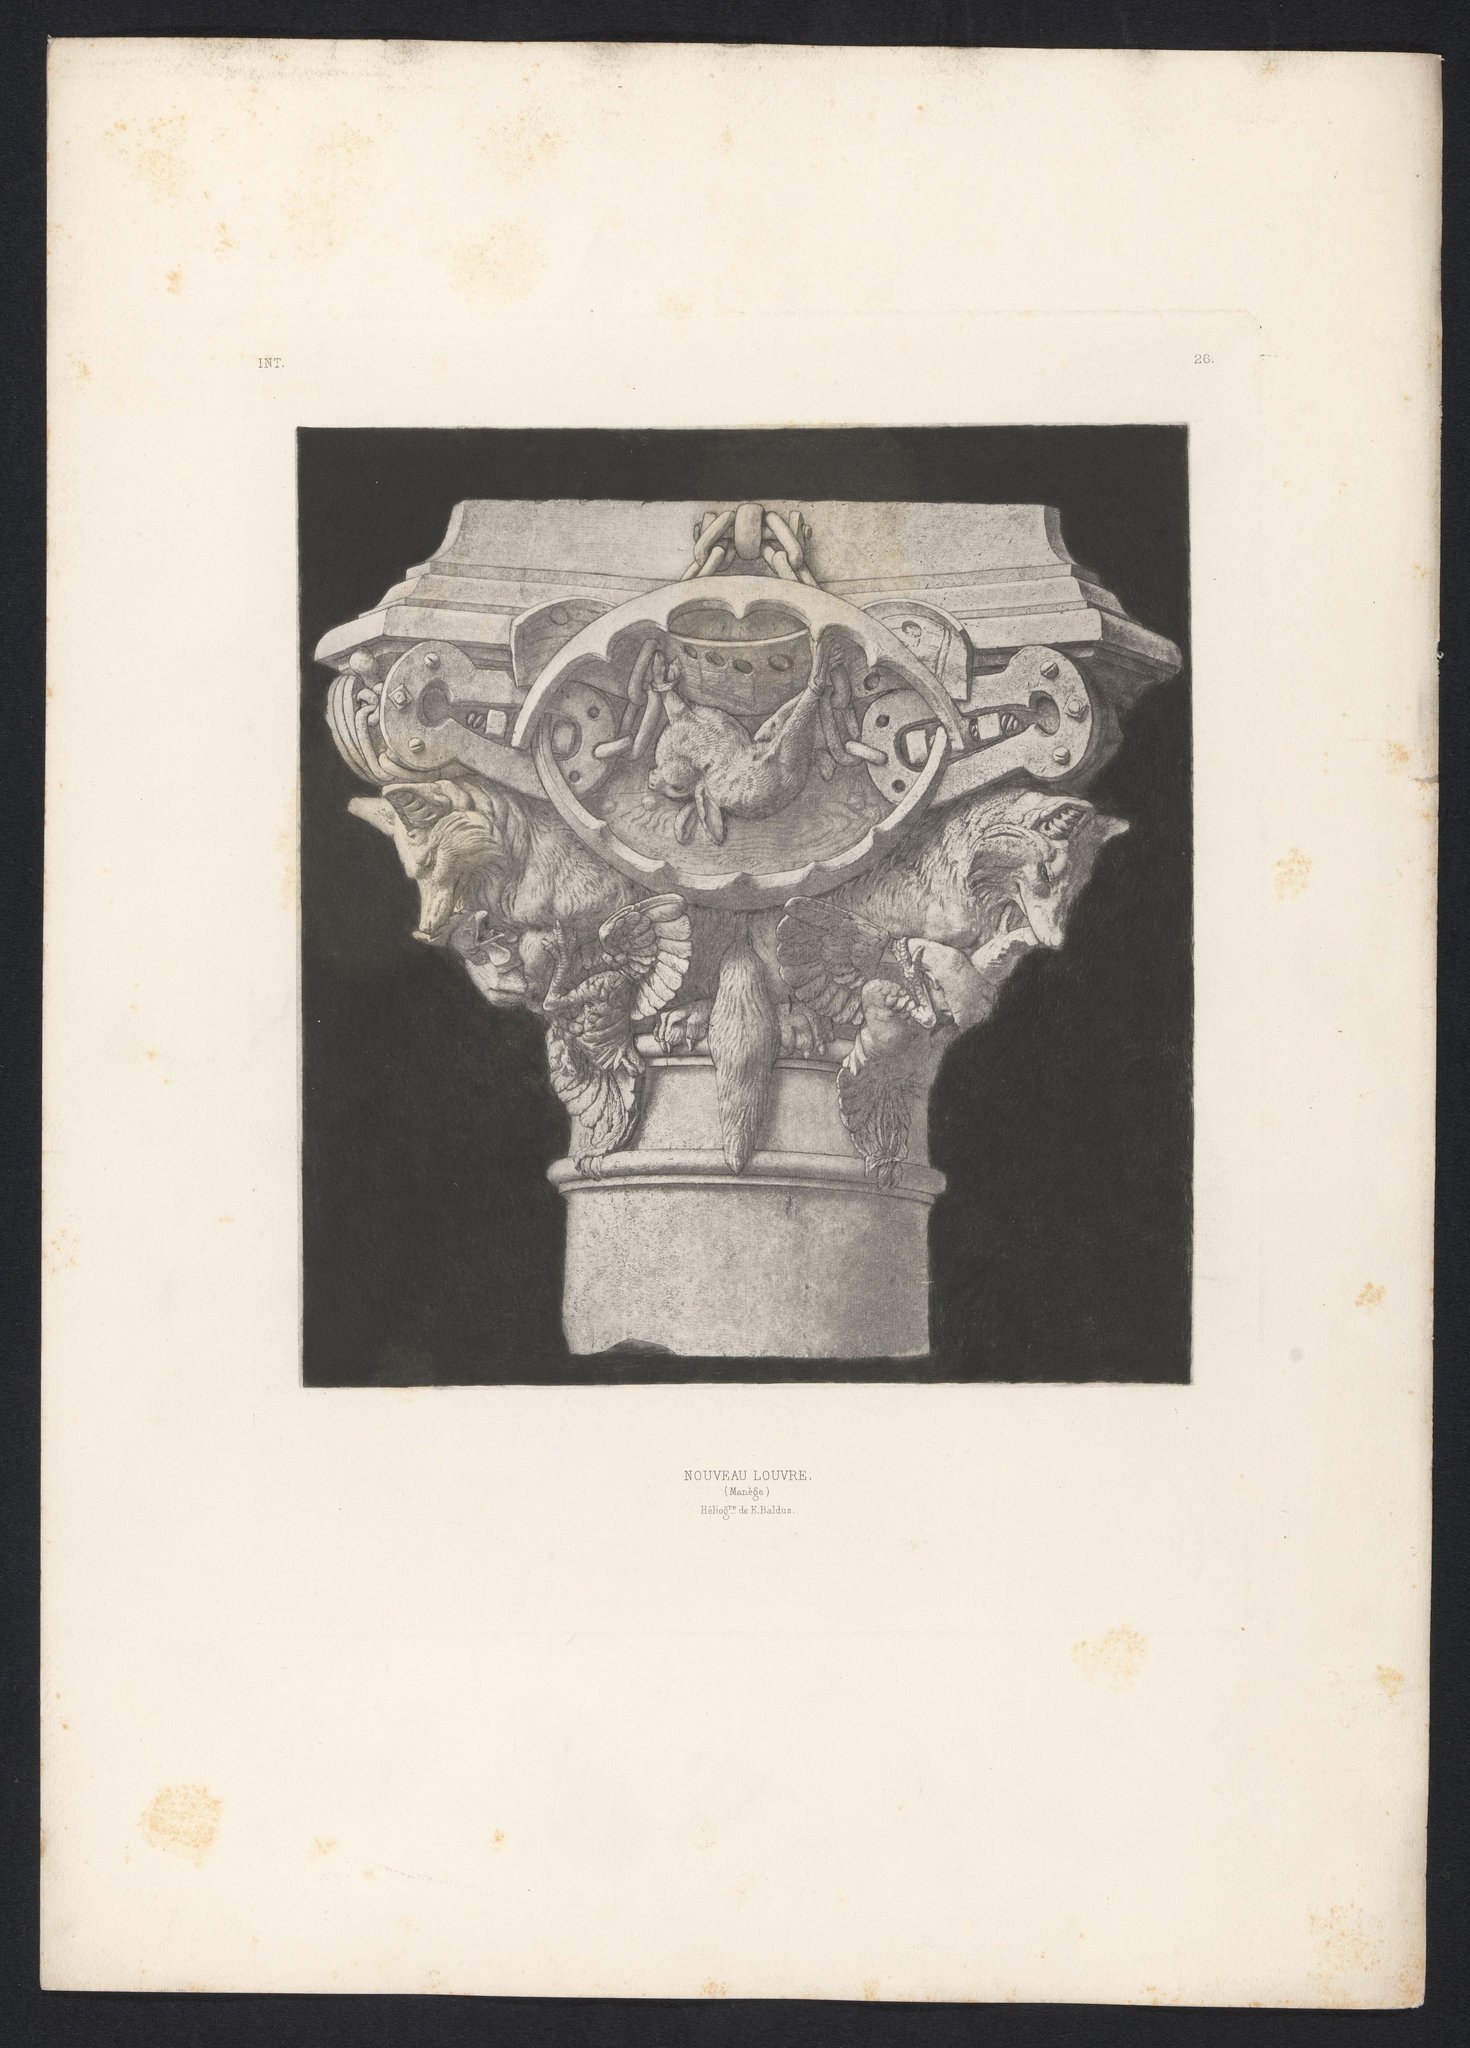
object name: photomechanical print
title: Fotoreproductie van een tekening, voorstellende een kapiteel met dierornamenten voor de Salle du Manège in het Palais du Louvre te Parijs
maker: édouard denis baldus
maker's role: fotograaf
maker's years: 1813-1889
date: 1865-1870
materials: paper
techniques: photoaquatint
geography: france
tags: ornament derived from animal forms, capital (~ column, pillar)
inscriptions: number: ‘Int. 26’